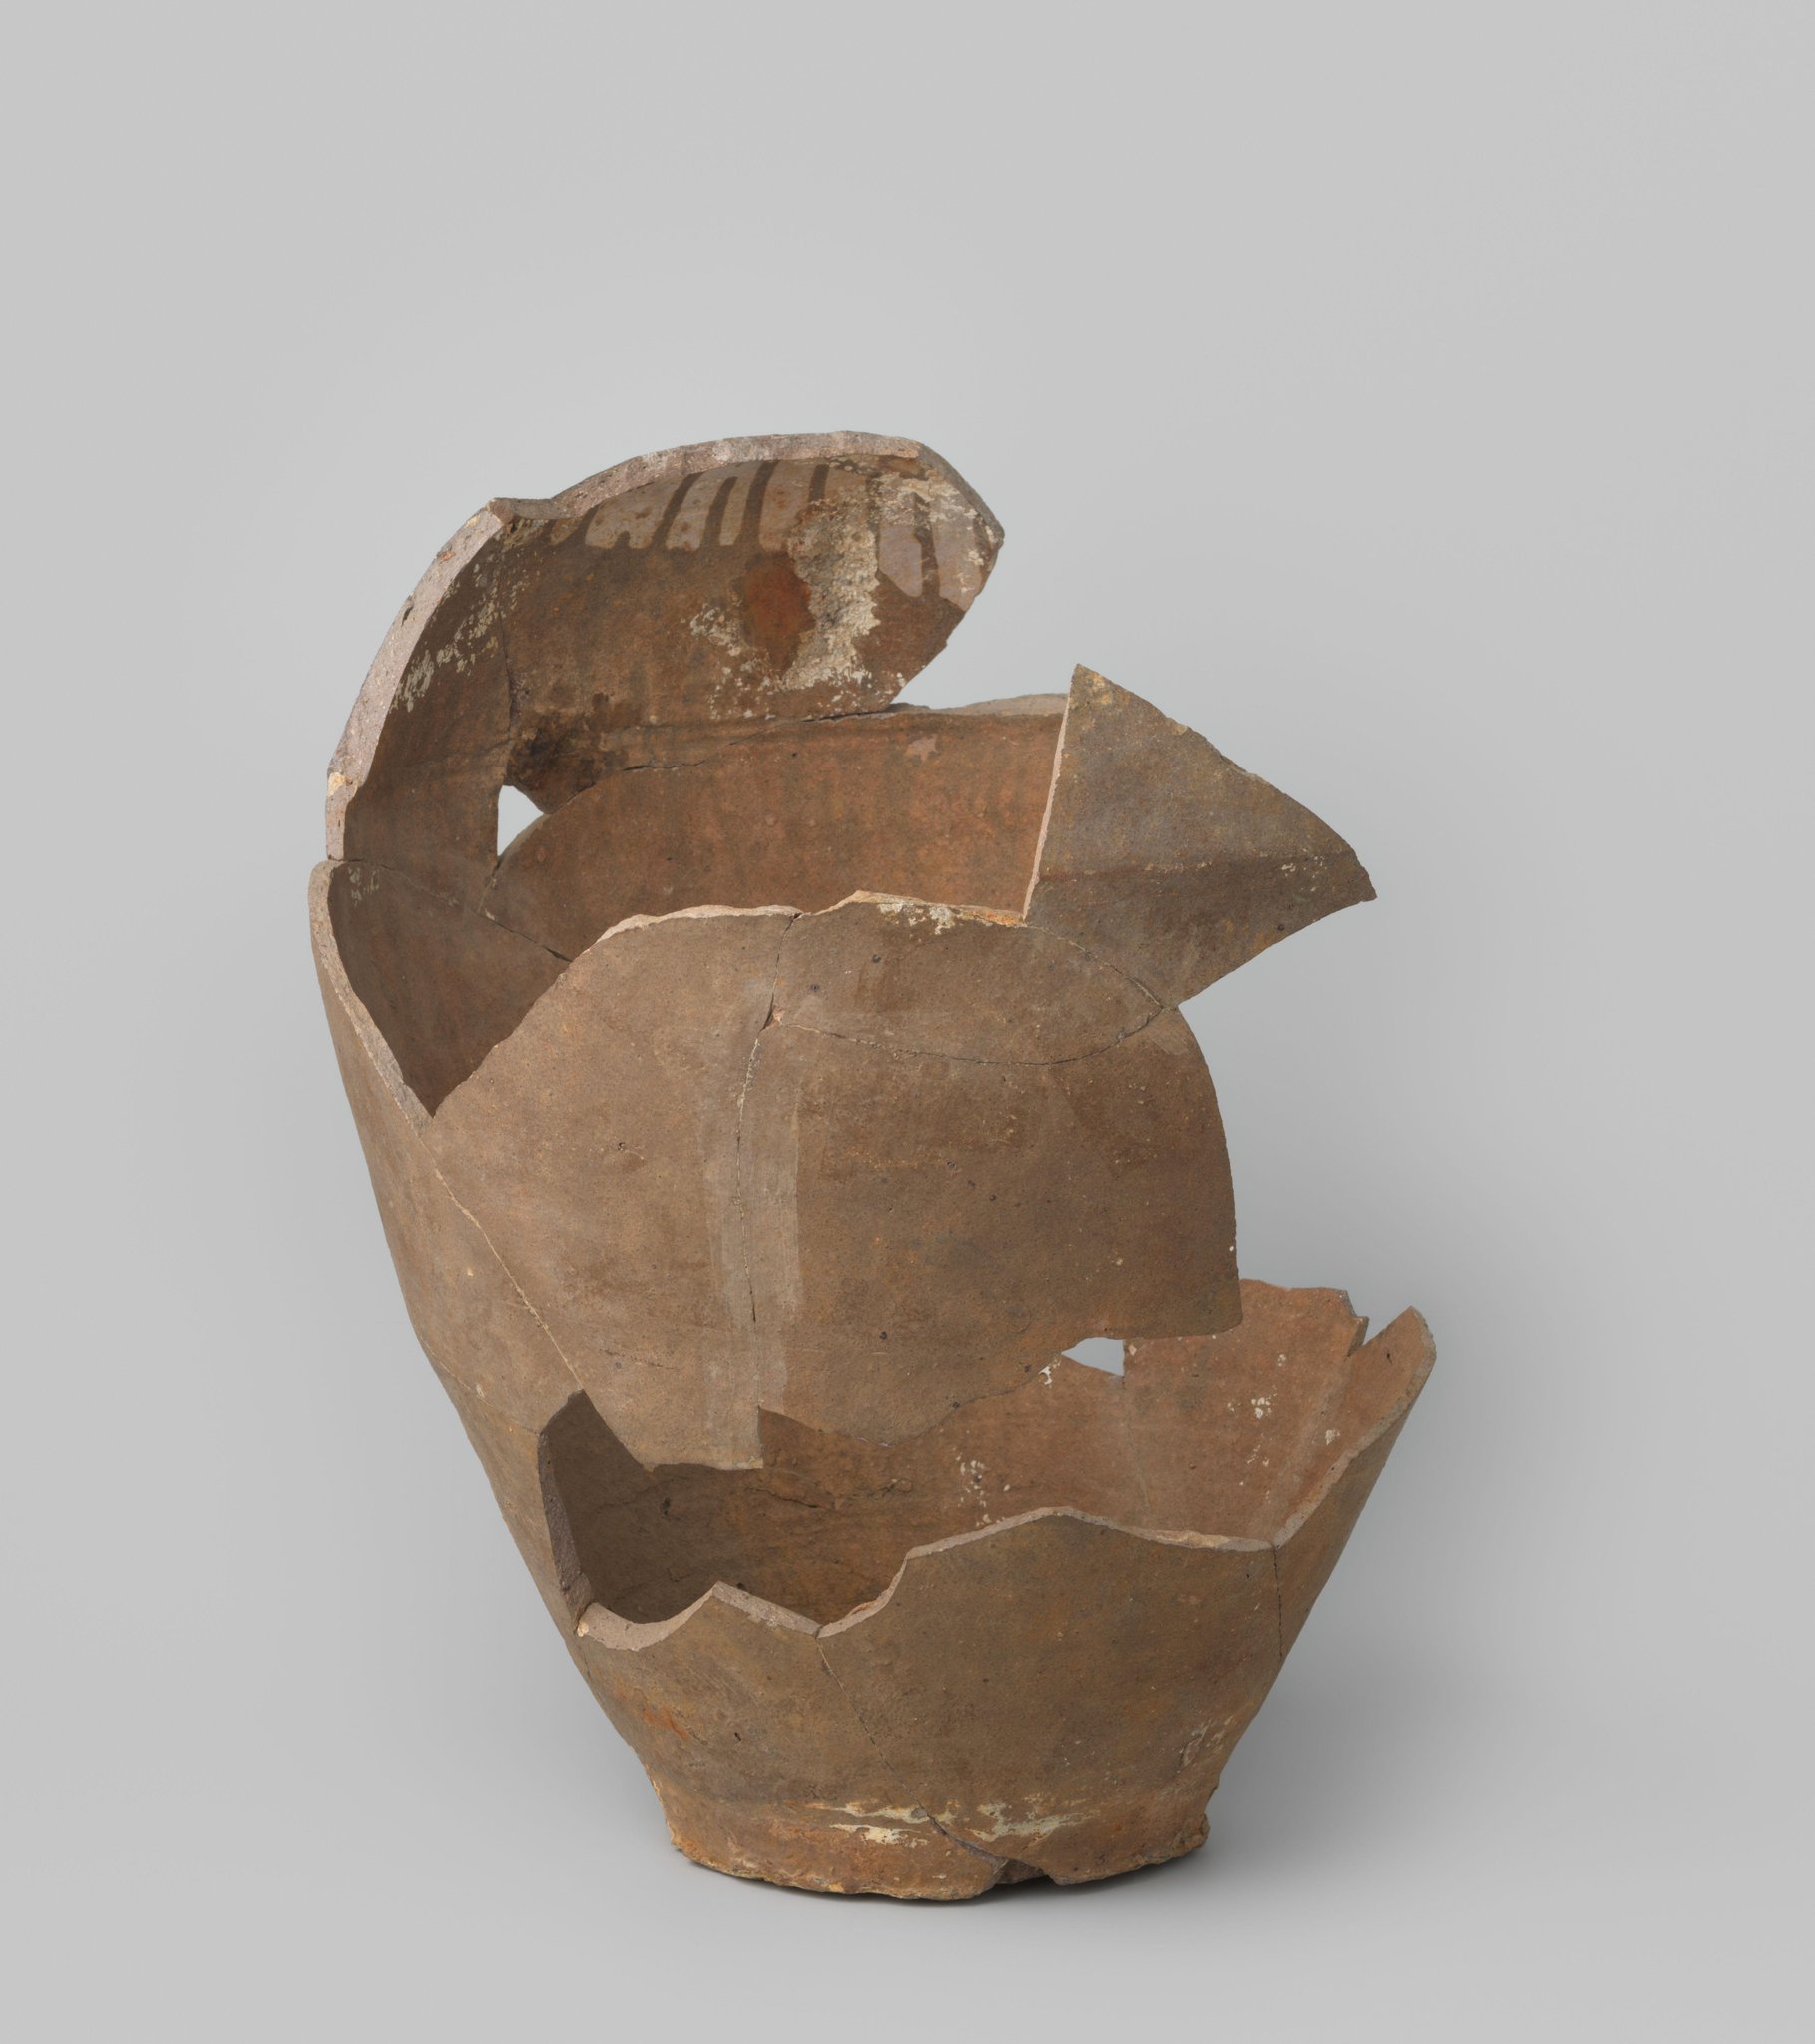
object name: vessel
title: Martavaan uit V.O.C.-schip de 'Witte Leeuw'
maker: Anonymous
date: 1613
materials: porcelain, stoneware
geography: southeast asia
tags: verenigde oostindische compagnie, sint-helena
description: A jar. This jar has probably had a lip neck and ears identical to inv nr. 12196. The upper half of the body is thicker. The base is slightly concave. The grey stoneware body has black and white and brownish impurities. The outside of the shoulder is covered with a grey and cream coloured glaze. Underneath this is a brown-greyish slip which covers the inside lower half and bottom, from which drippings run out to the shoulder.